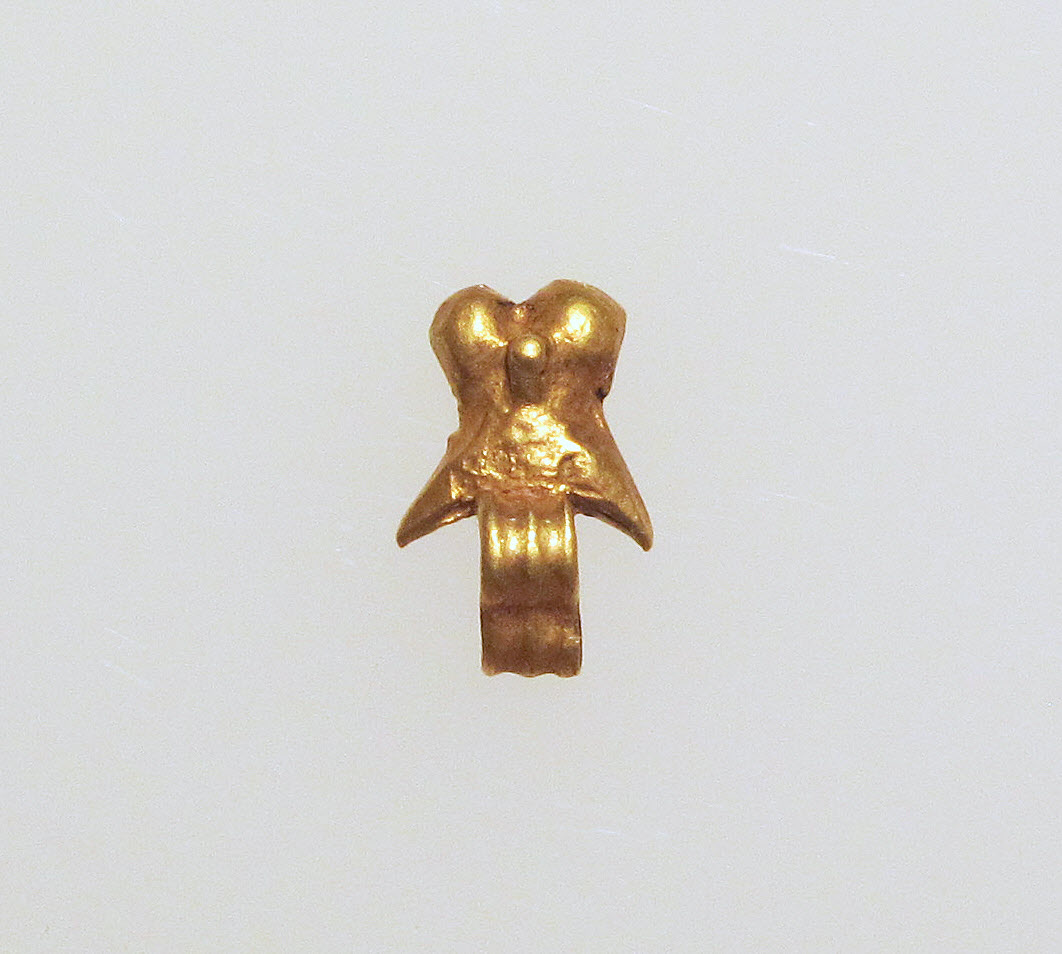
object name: pendant, aidoion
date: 7000 BCE-330 CE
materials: gold